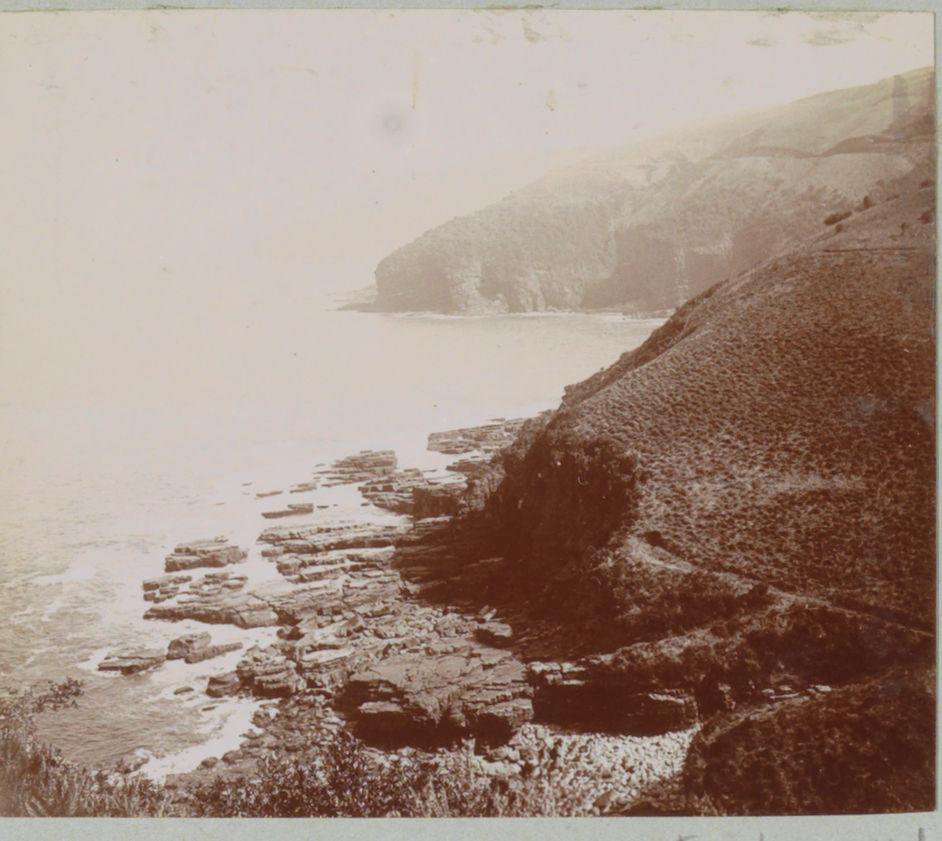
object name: photograph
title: Gezicht op een bergachtige kust, vermoedelijk in Frans of Spaans Baskenland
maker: delizy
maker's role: manufacturer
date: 1904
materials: paper, photographic support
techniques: gelatin silver print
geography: lekeitio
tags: coast, france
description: Onderdeel van Fotoalbum van een Franse amateurfotograaf met opnames van uitstapjes in Frankrijk, Spanje, België, Luxemburg en Nederland, de eerste automobielen en autoraces.